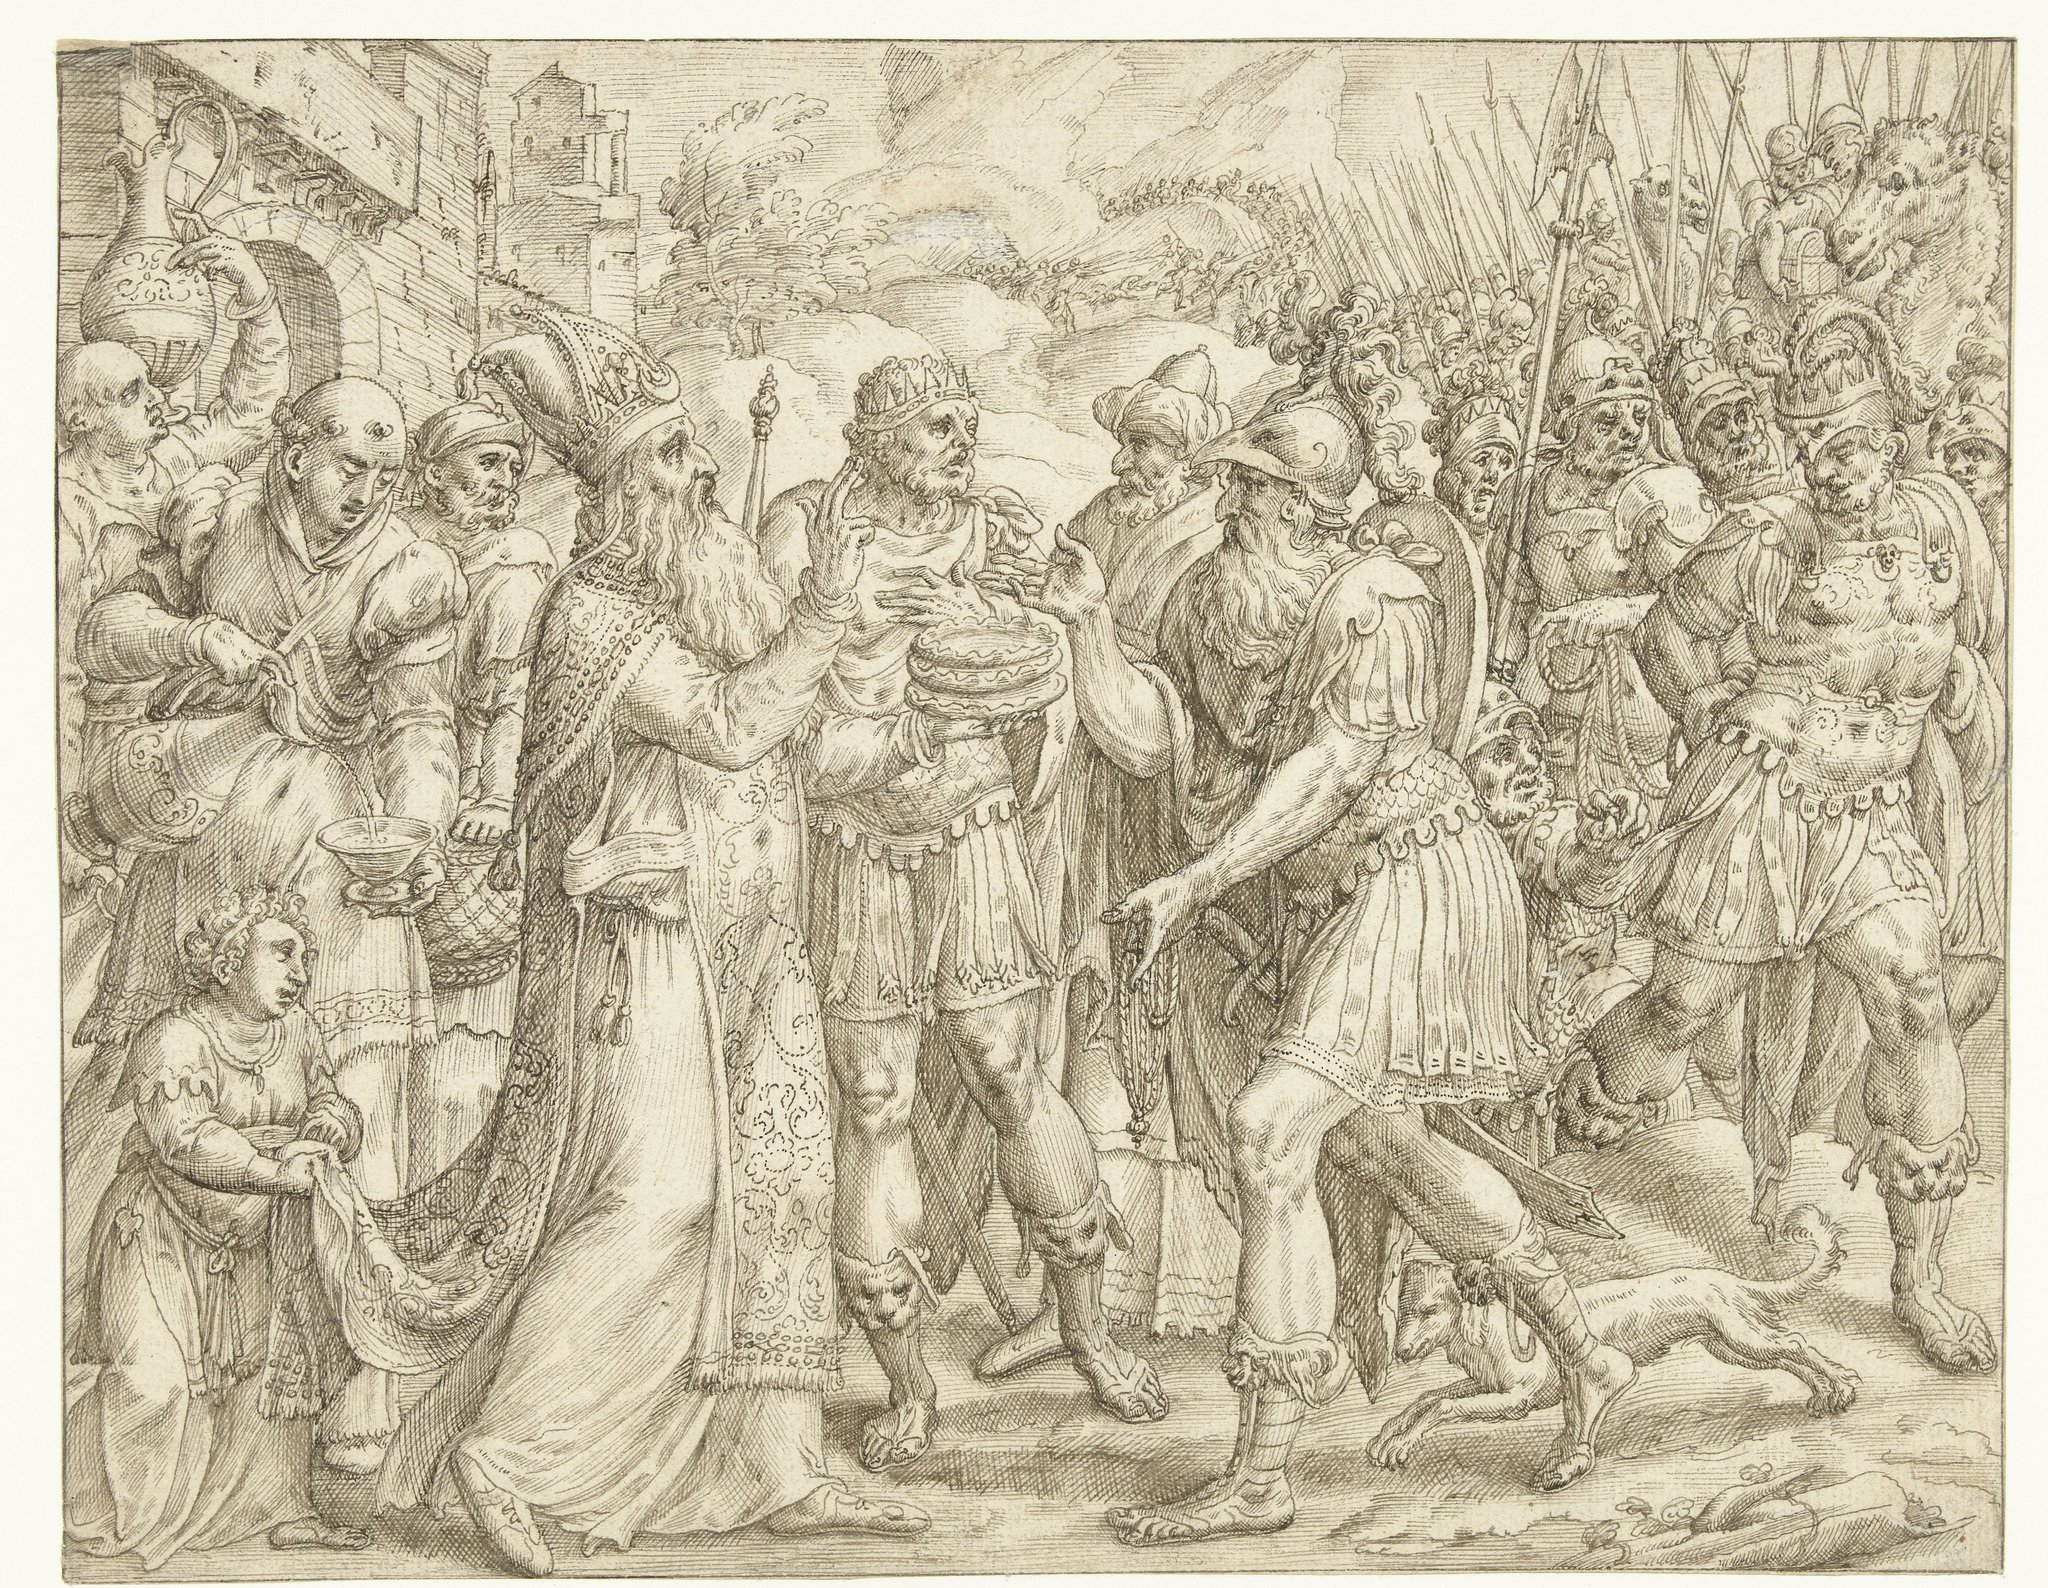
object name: drawing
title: Abraham en Melchisedek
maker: gerard van groeningen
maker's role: draughtsman, painter, print maker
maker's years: 1515-1599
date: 1560-1580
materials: chalk, ink, paper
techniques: pen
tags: the meeting of abraham and melchizedek, the high priest and king of salem, who brings bread and wine (genesis 14:18-20)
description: Links Melchizedek, koning en hoge priester van Salem., op weg maar zijn ontmoeting met Abraham met een brood offer. Achter hem, een wijn hofmeester die wijn in een beker giet. Rechts staat Abraham gevolgd door één van koningen die hij verslagen heeft.